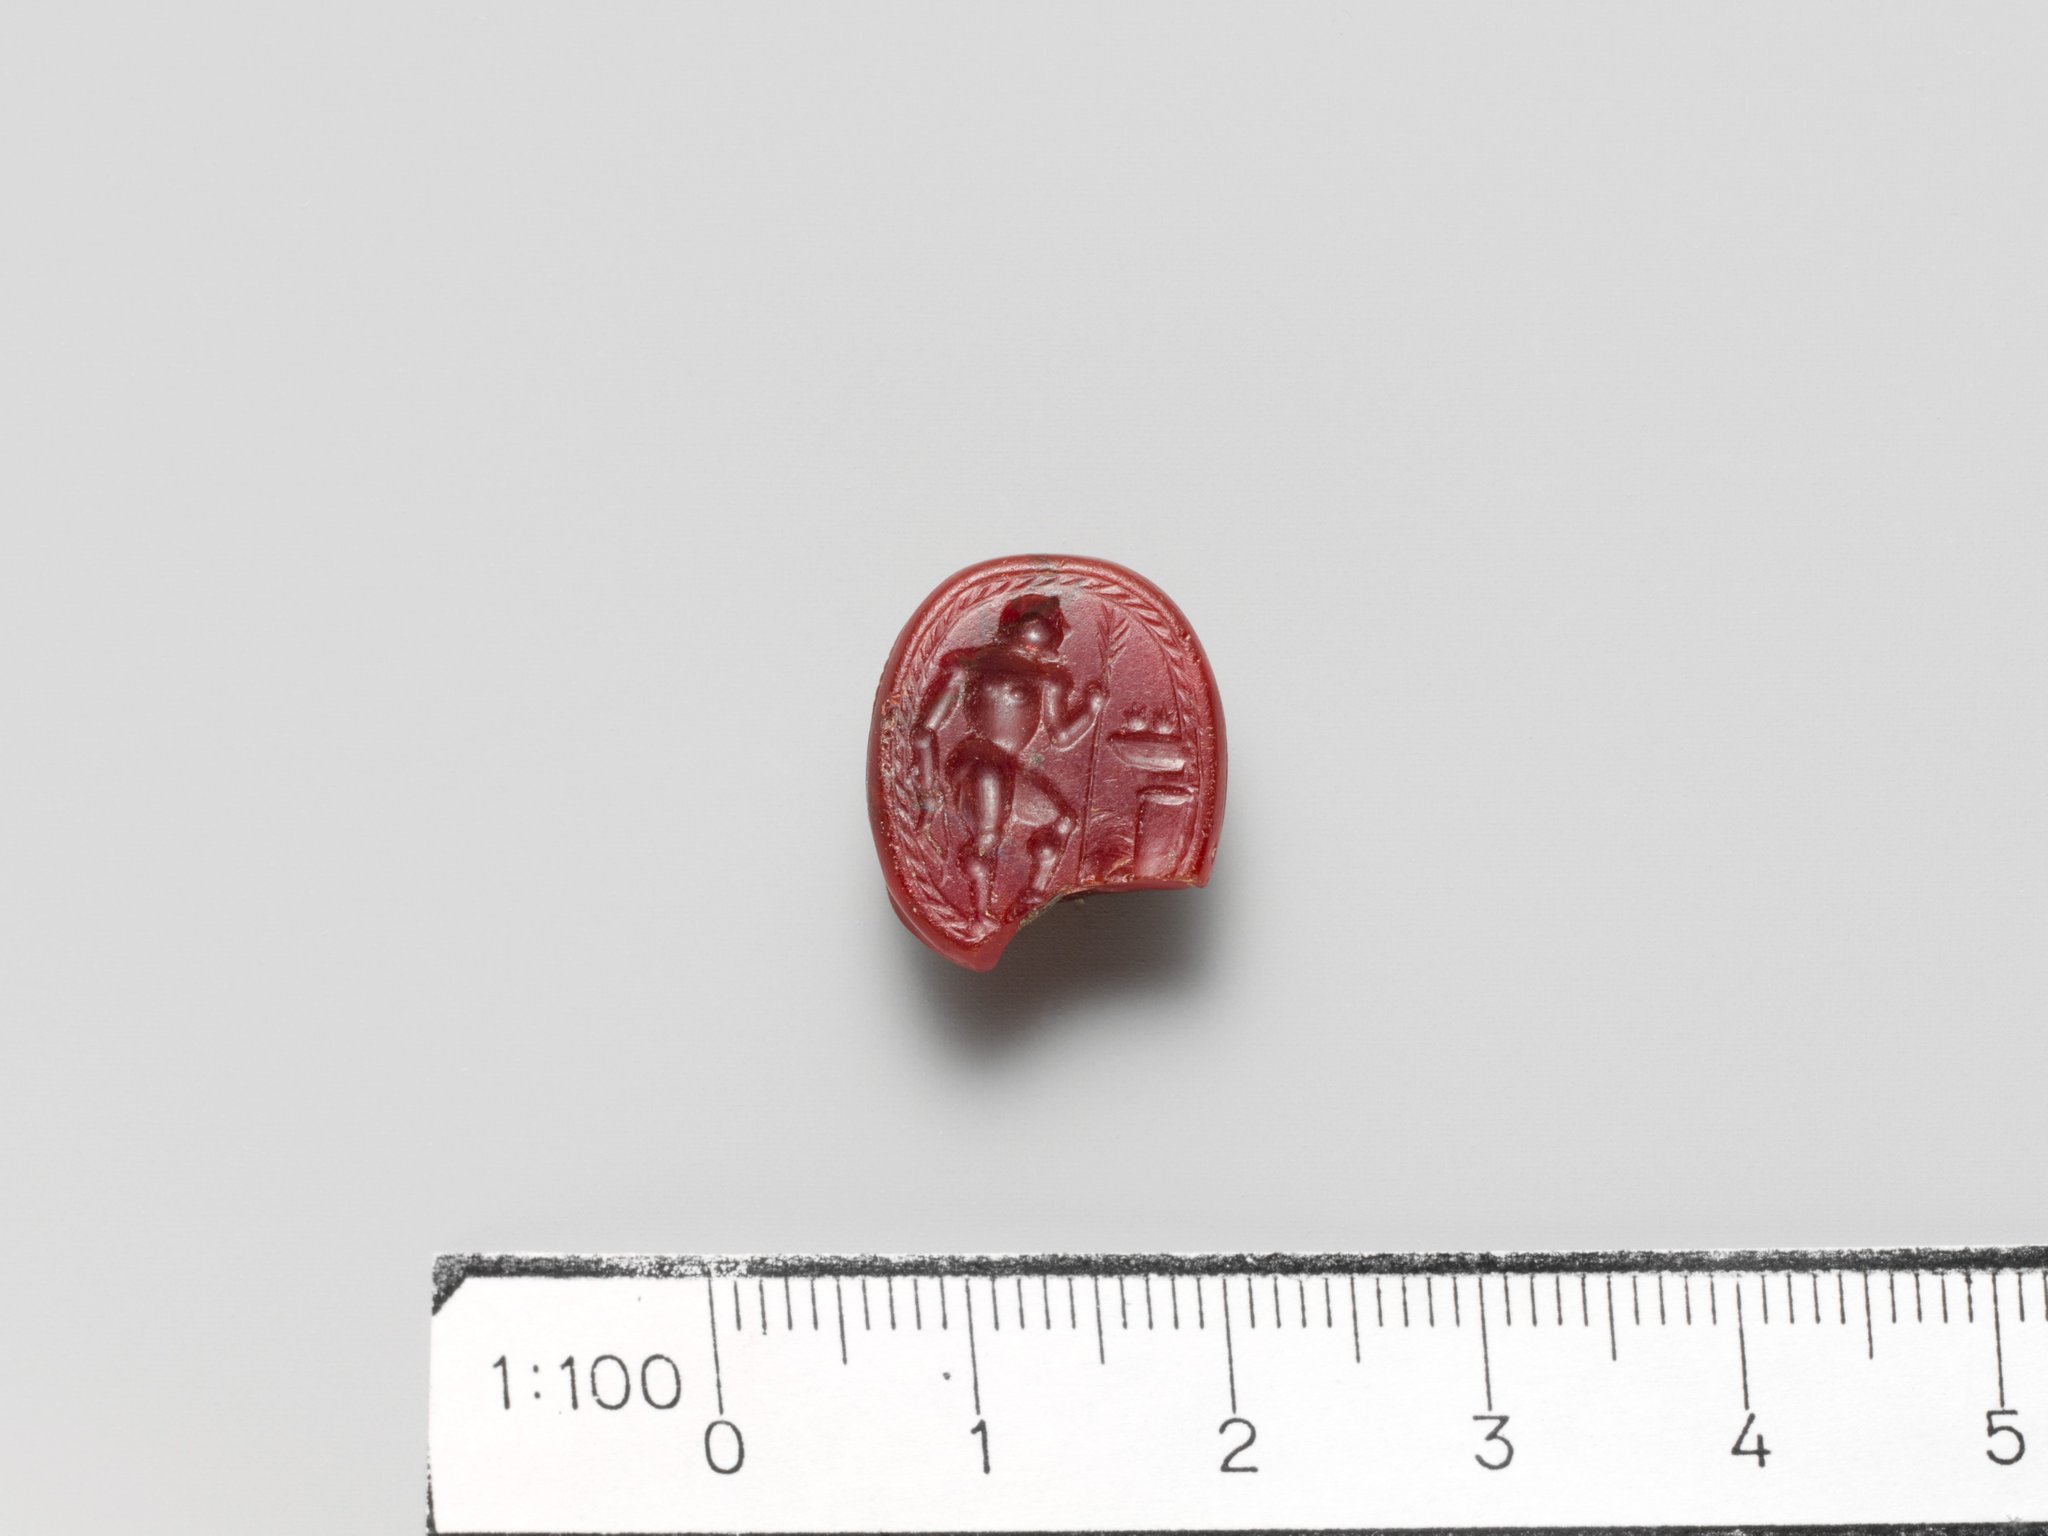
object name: scarab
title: Carnelian scarab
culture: etruscan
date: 300-201 BCE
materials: gemstone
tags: altars,male nudes